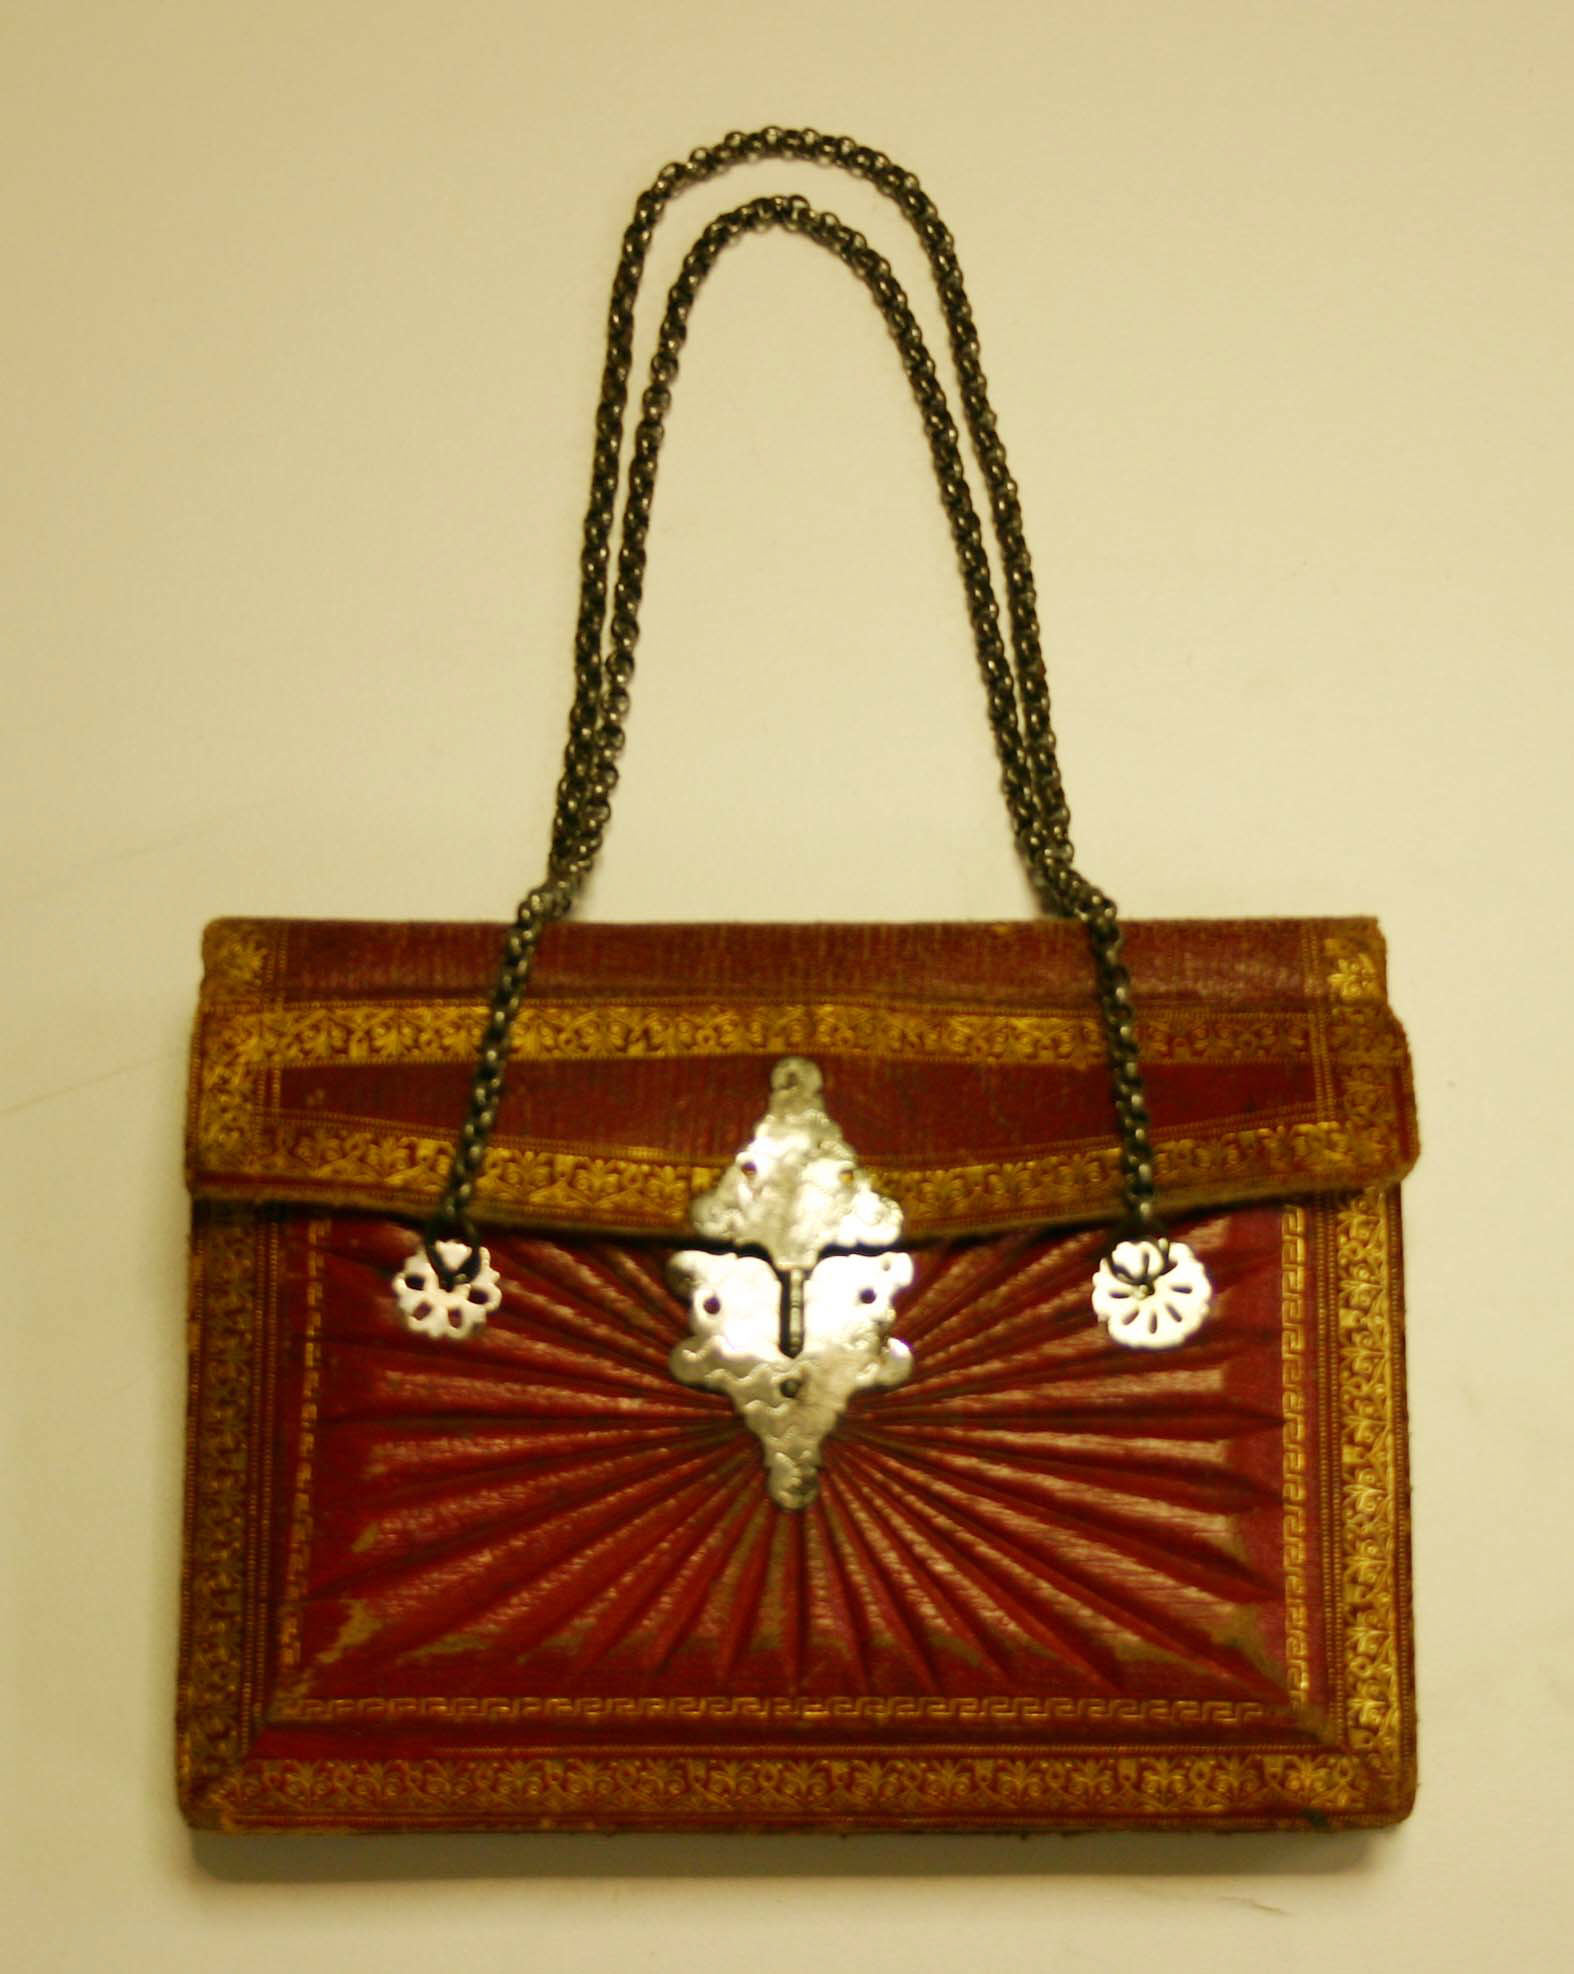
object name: reticule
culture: french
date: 1801-1833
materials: leather, metal, shell